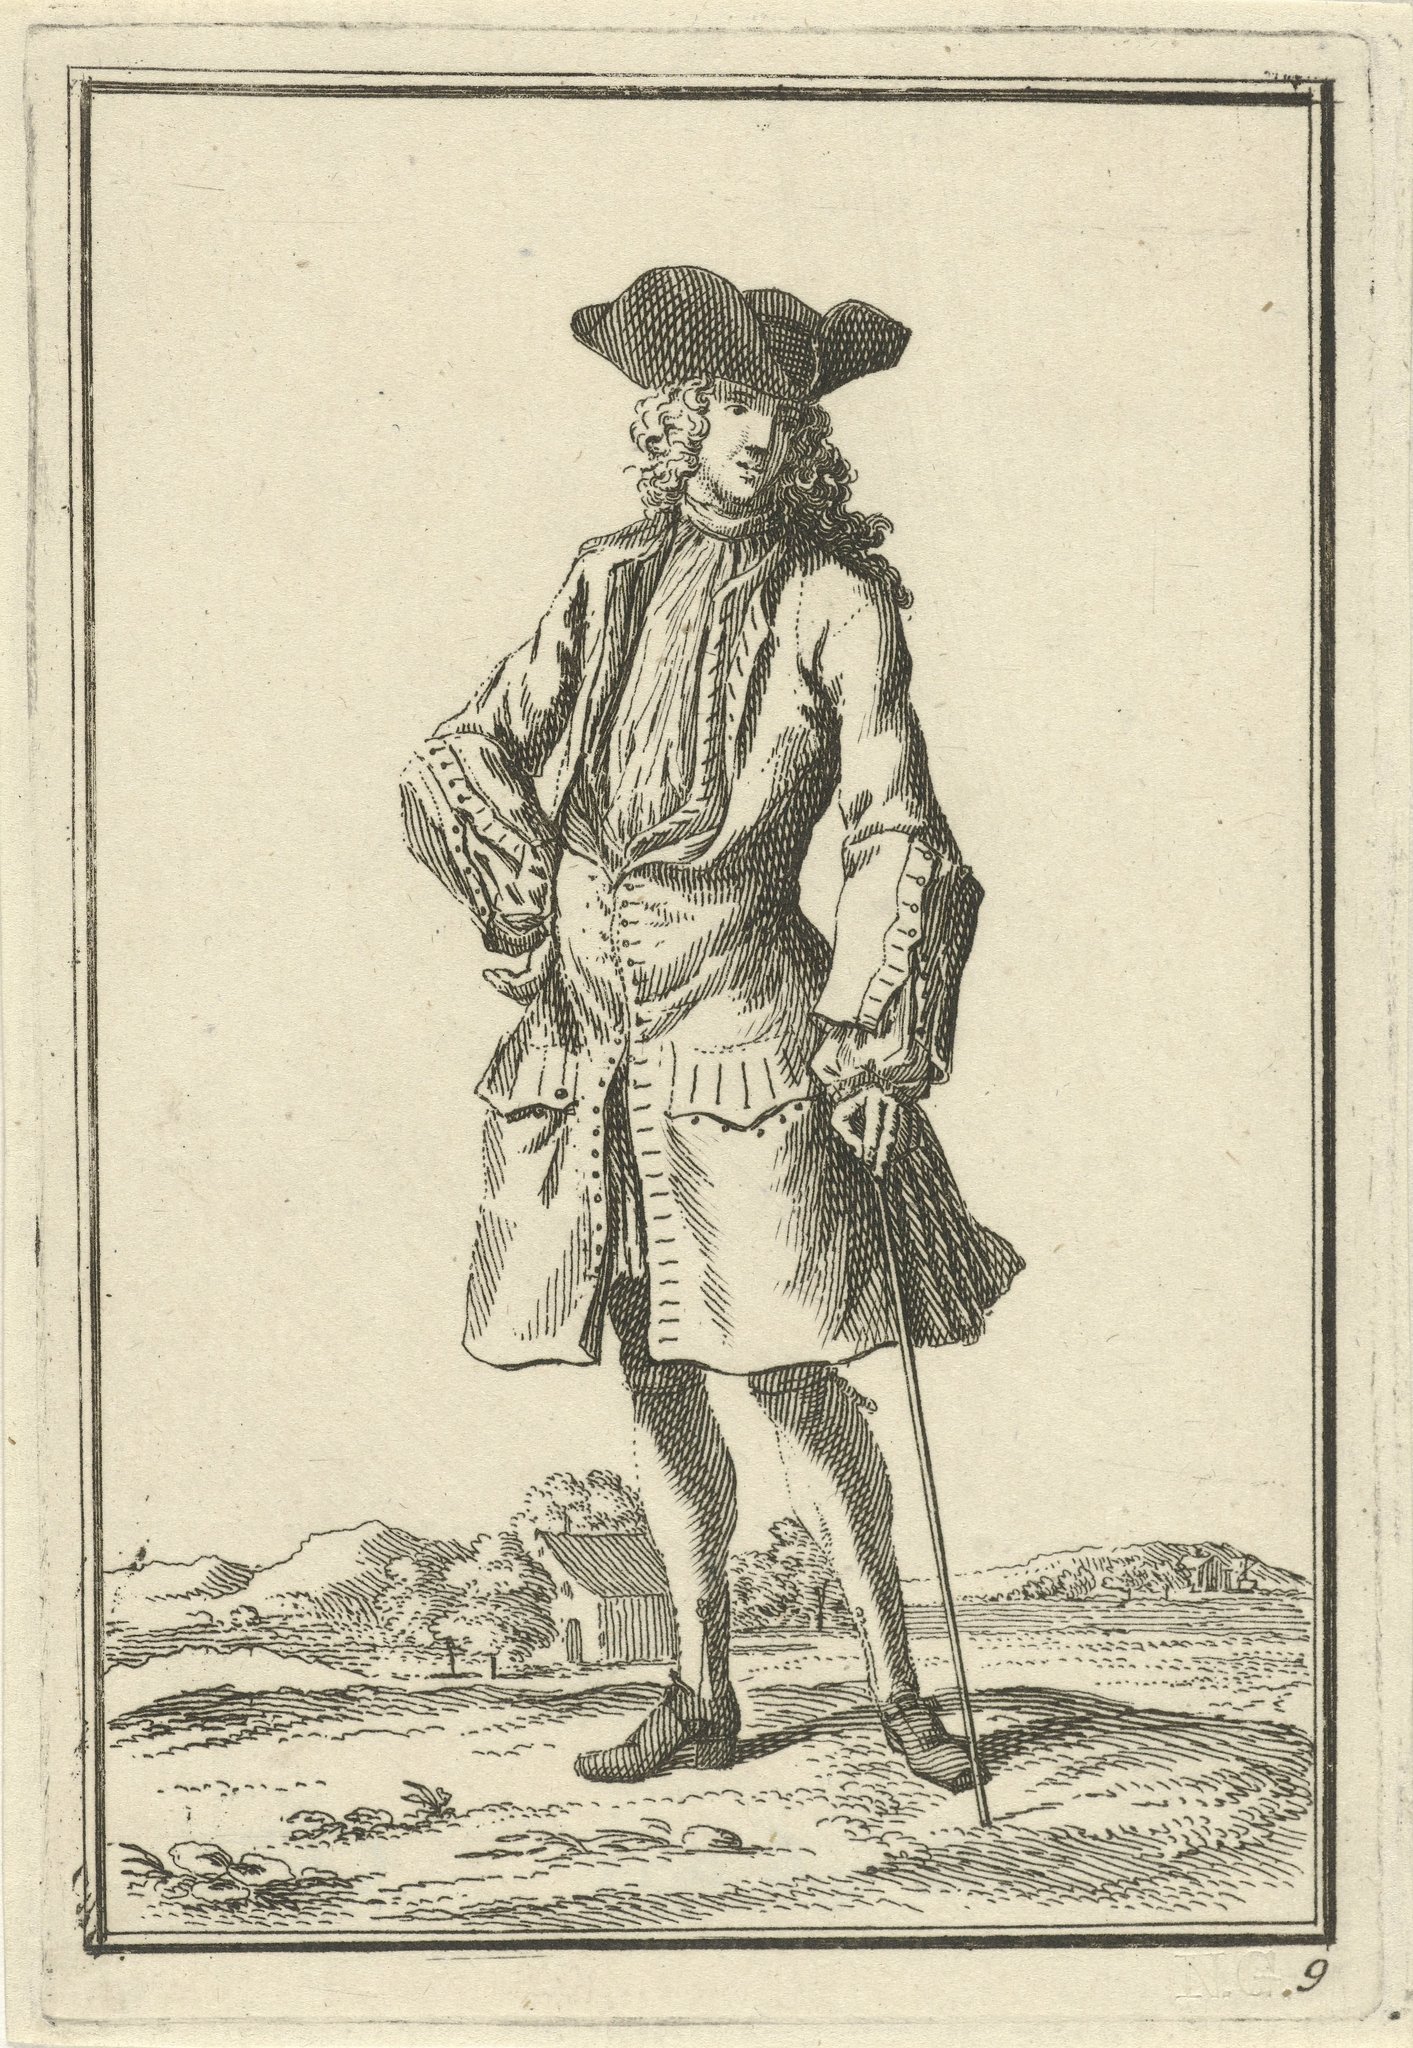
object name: costume print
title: Man met hoed en wandelstok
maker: adolf van der laan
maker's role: draughtsman, print maker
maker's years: 1689-1742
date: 1710-1755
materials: paper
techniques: etching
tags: europeans (with name) (+ costume), clothes, costume (+ men's clothes)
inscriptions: collector's mark: Lugt 1967, collector's mark: Lugt 2228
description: Man in een landschap, gekleed volgens de Hollandse mode van 1710-1720. Ten voeten uit, met hoed op het hoofd en een wandelstok in de linkerhand. De prent maakt deel uit van een zestiendelige serie prenten met voorstellingen van Hollandse kostuums.